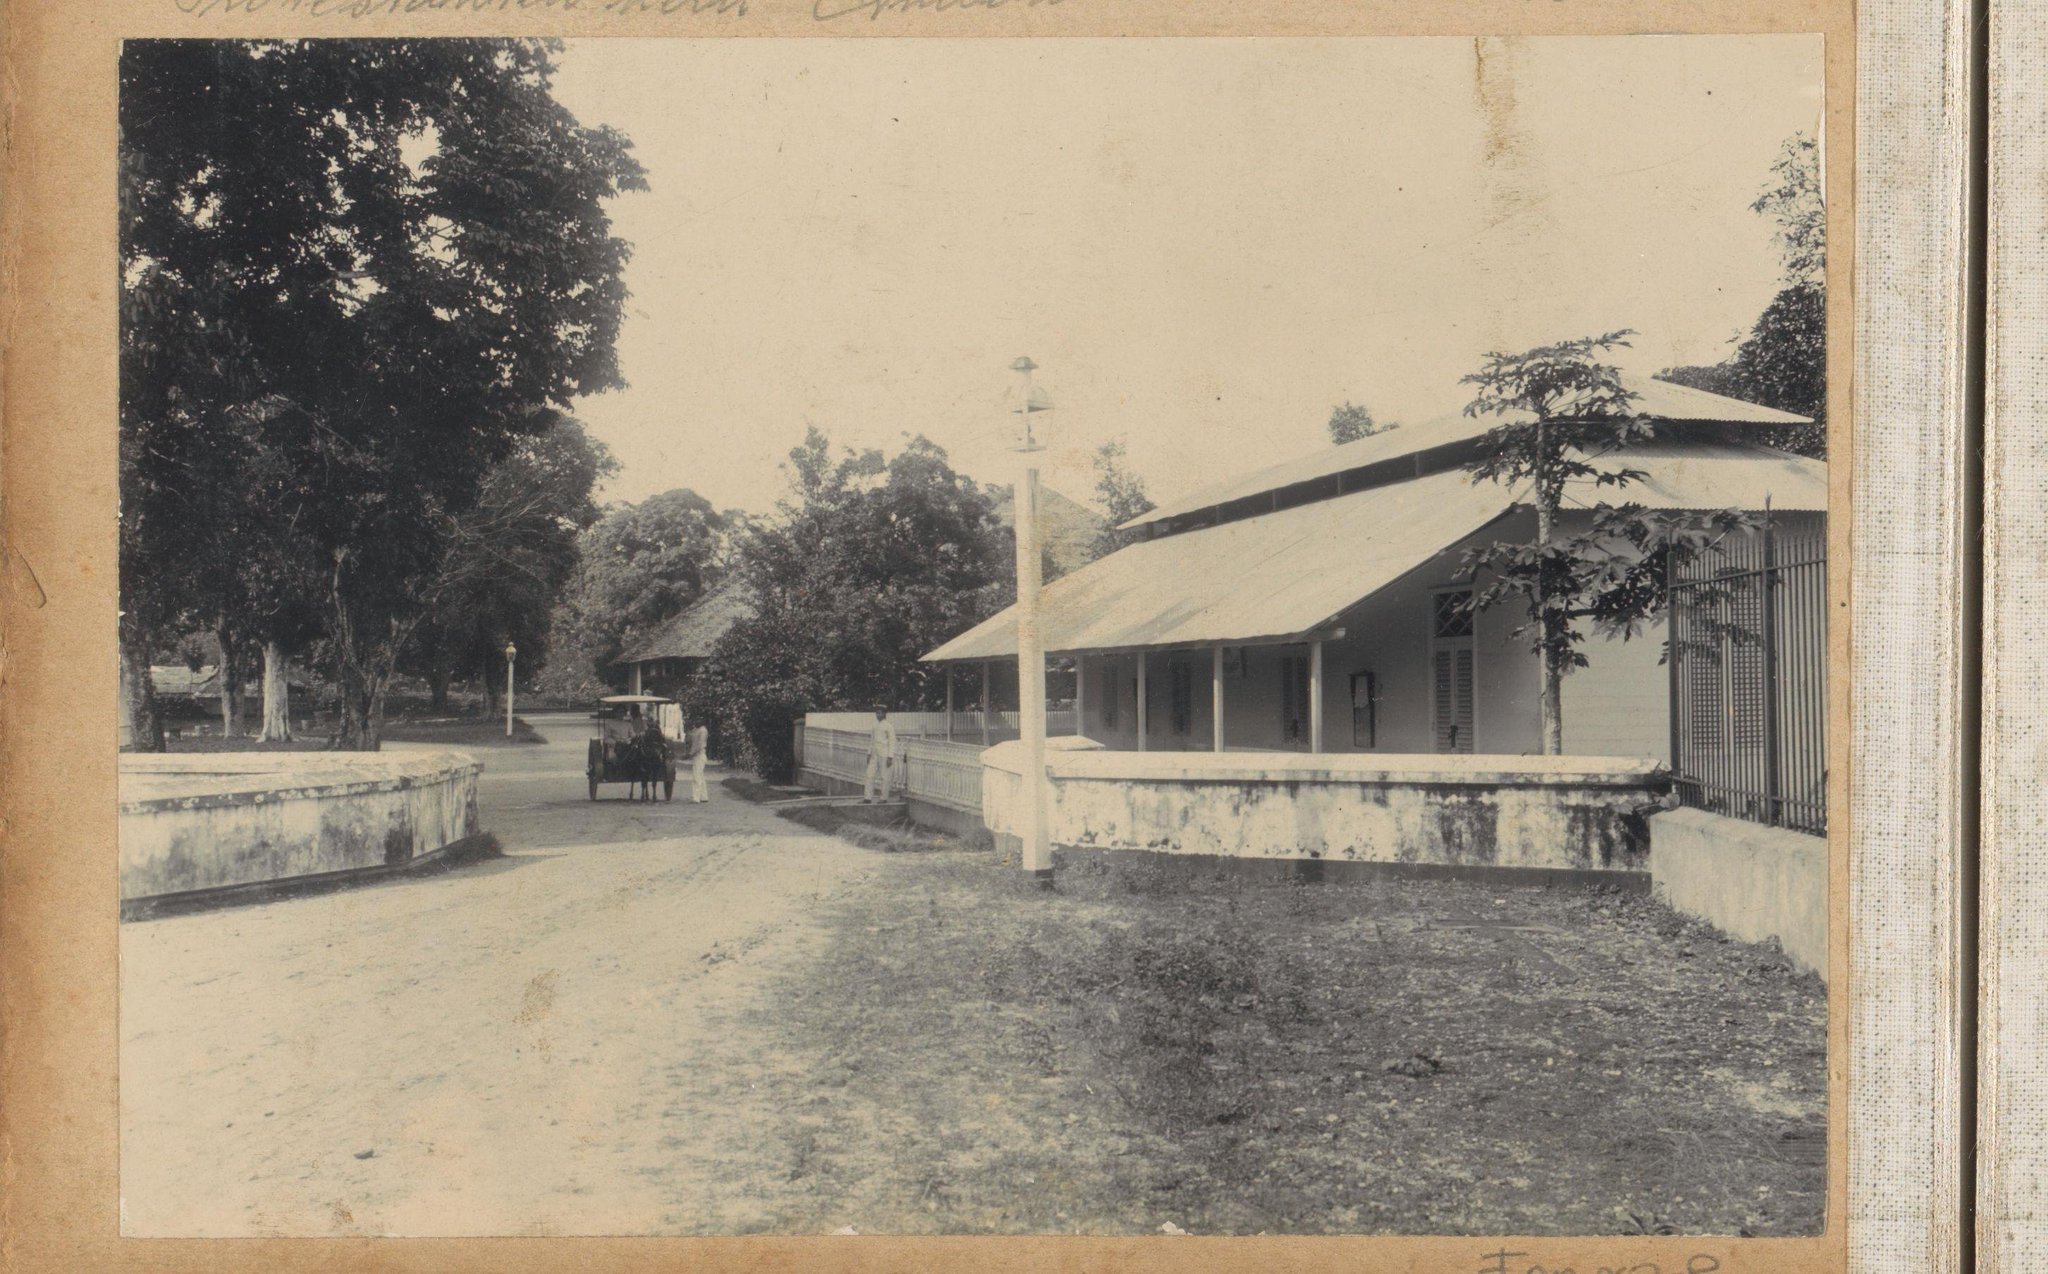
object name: album leaf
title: Straatgezicht met koets op Ambon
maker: Anonymous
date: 1900-1920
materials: cardboard, paper, photographic support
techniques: gelatin silver print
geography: ambon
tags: street (+ city(-scape) with figures, staffage), dutch east indies, the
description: Onderdeel van Reisalbum met foto's van Ambon.